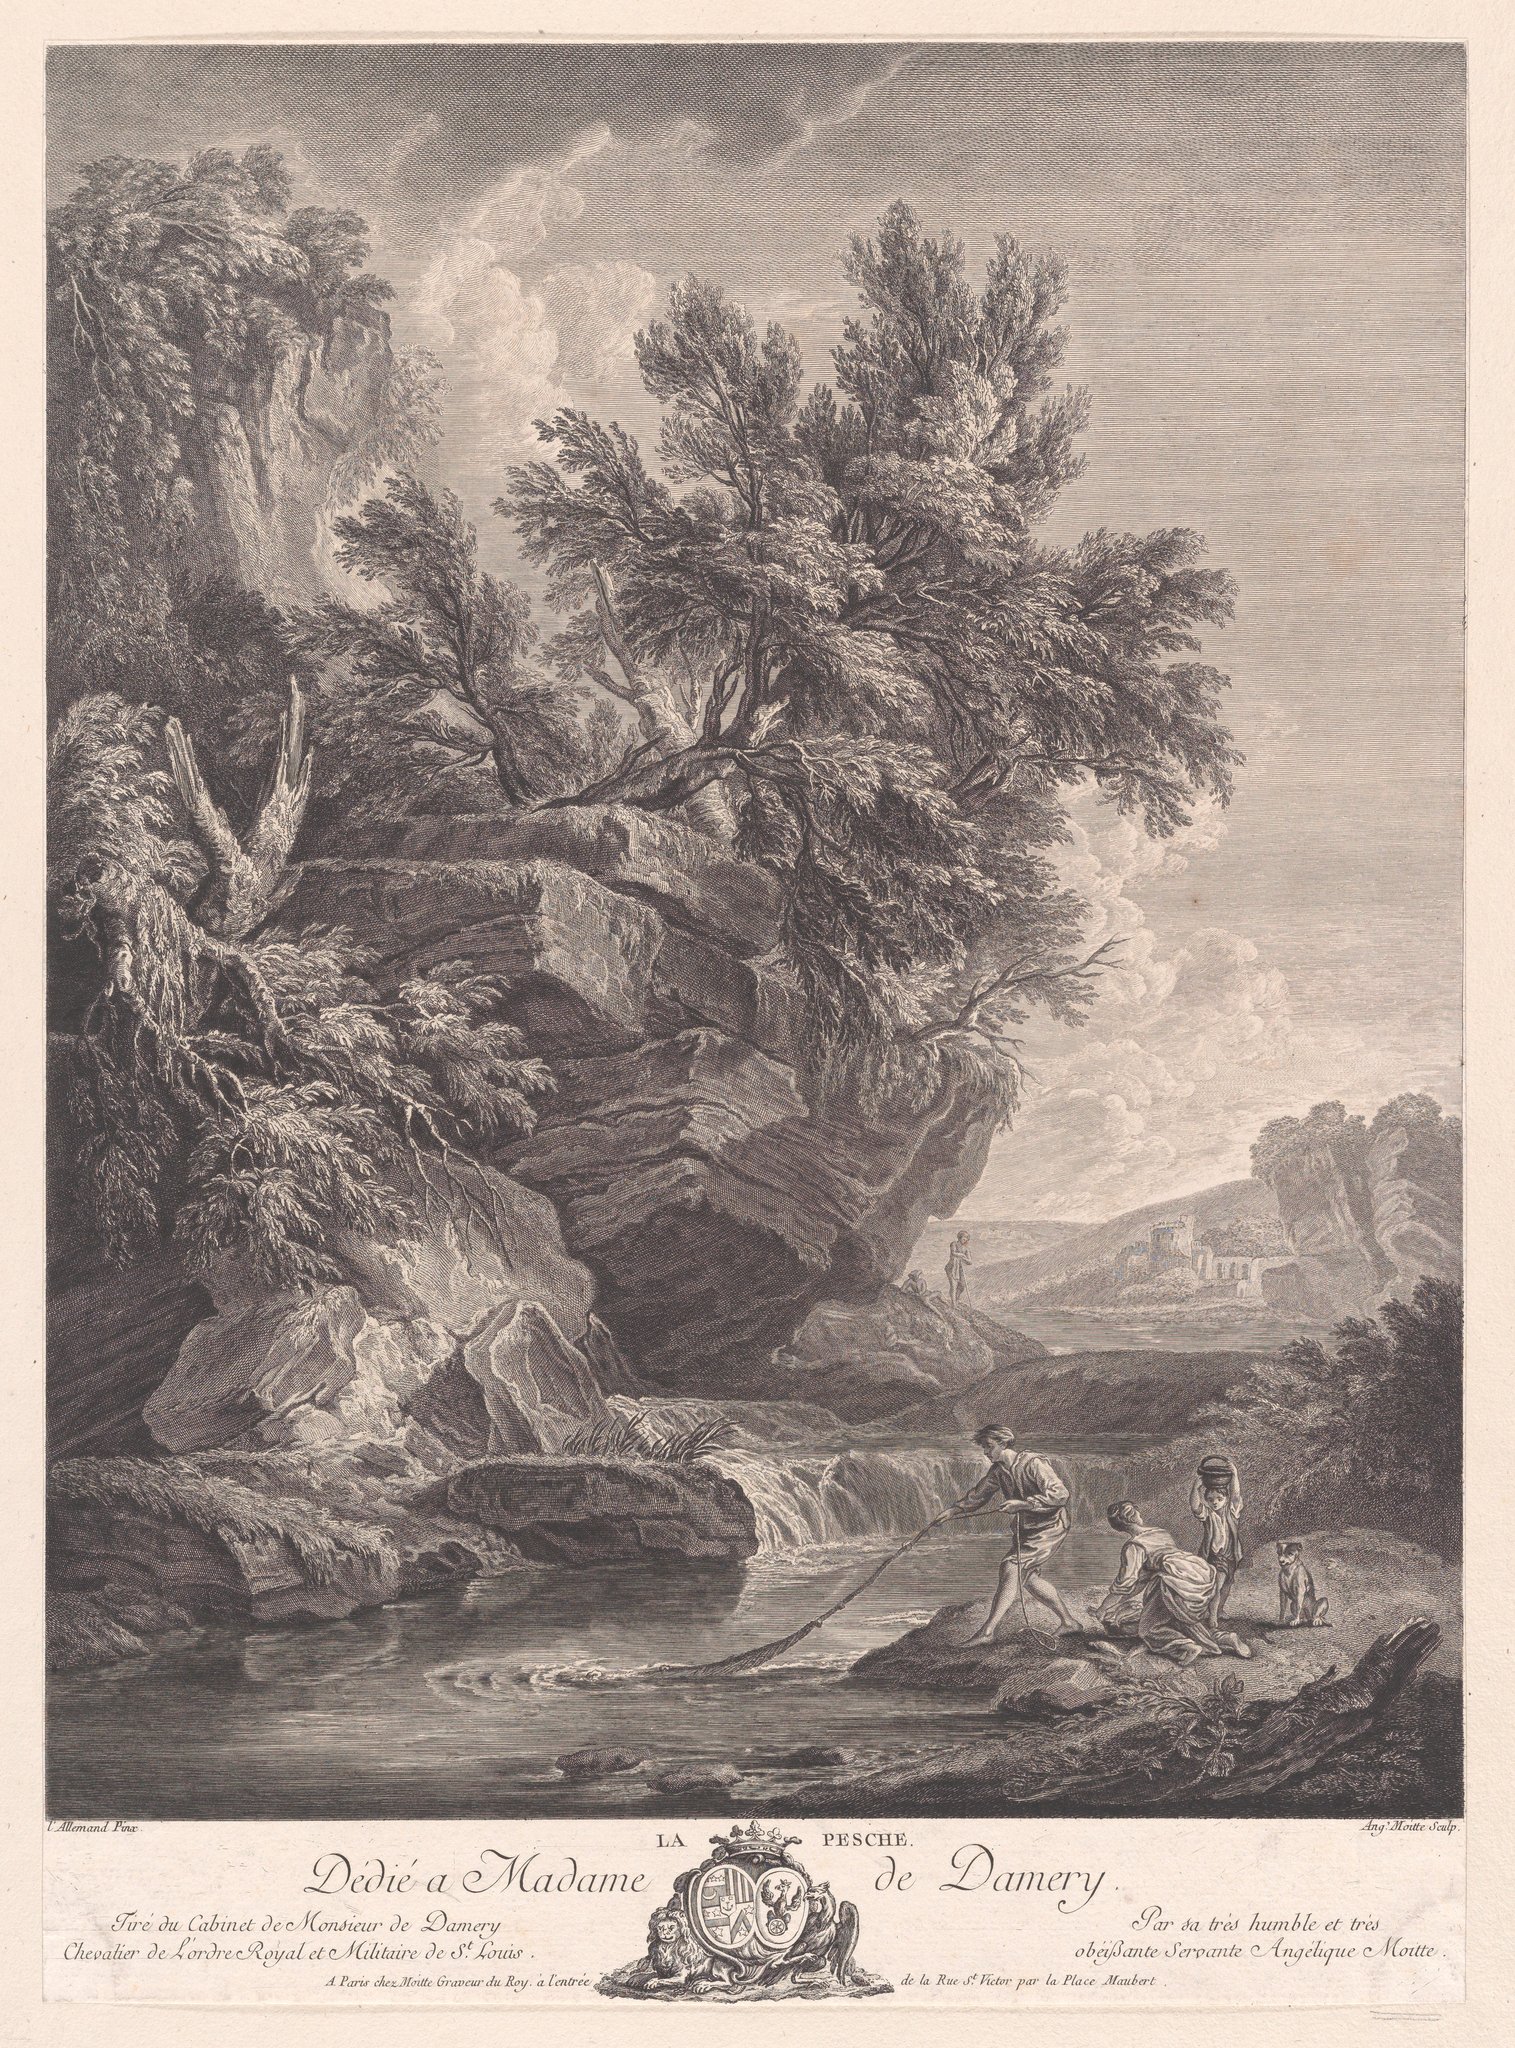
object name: print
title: Fishing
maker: angélique moitte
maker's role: artist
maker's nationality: french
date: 1770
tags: fishing,landscapes,coat of arms